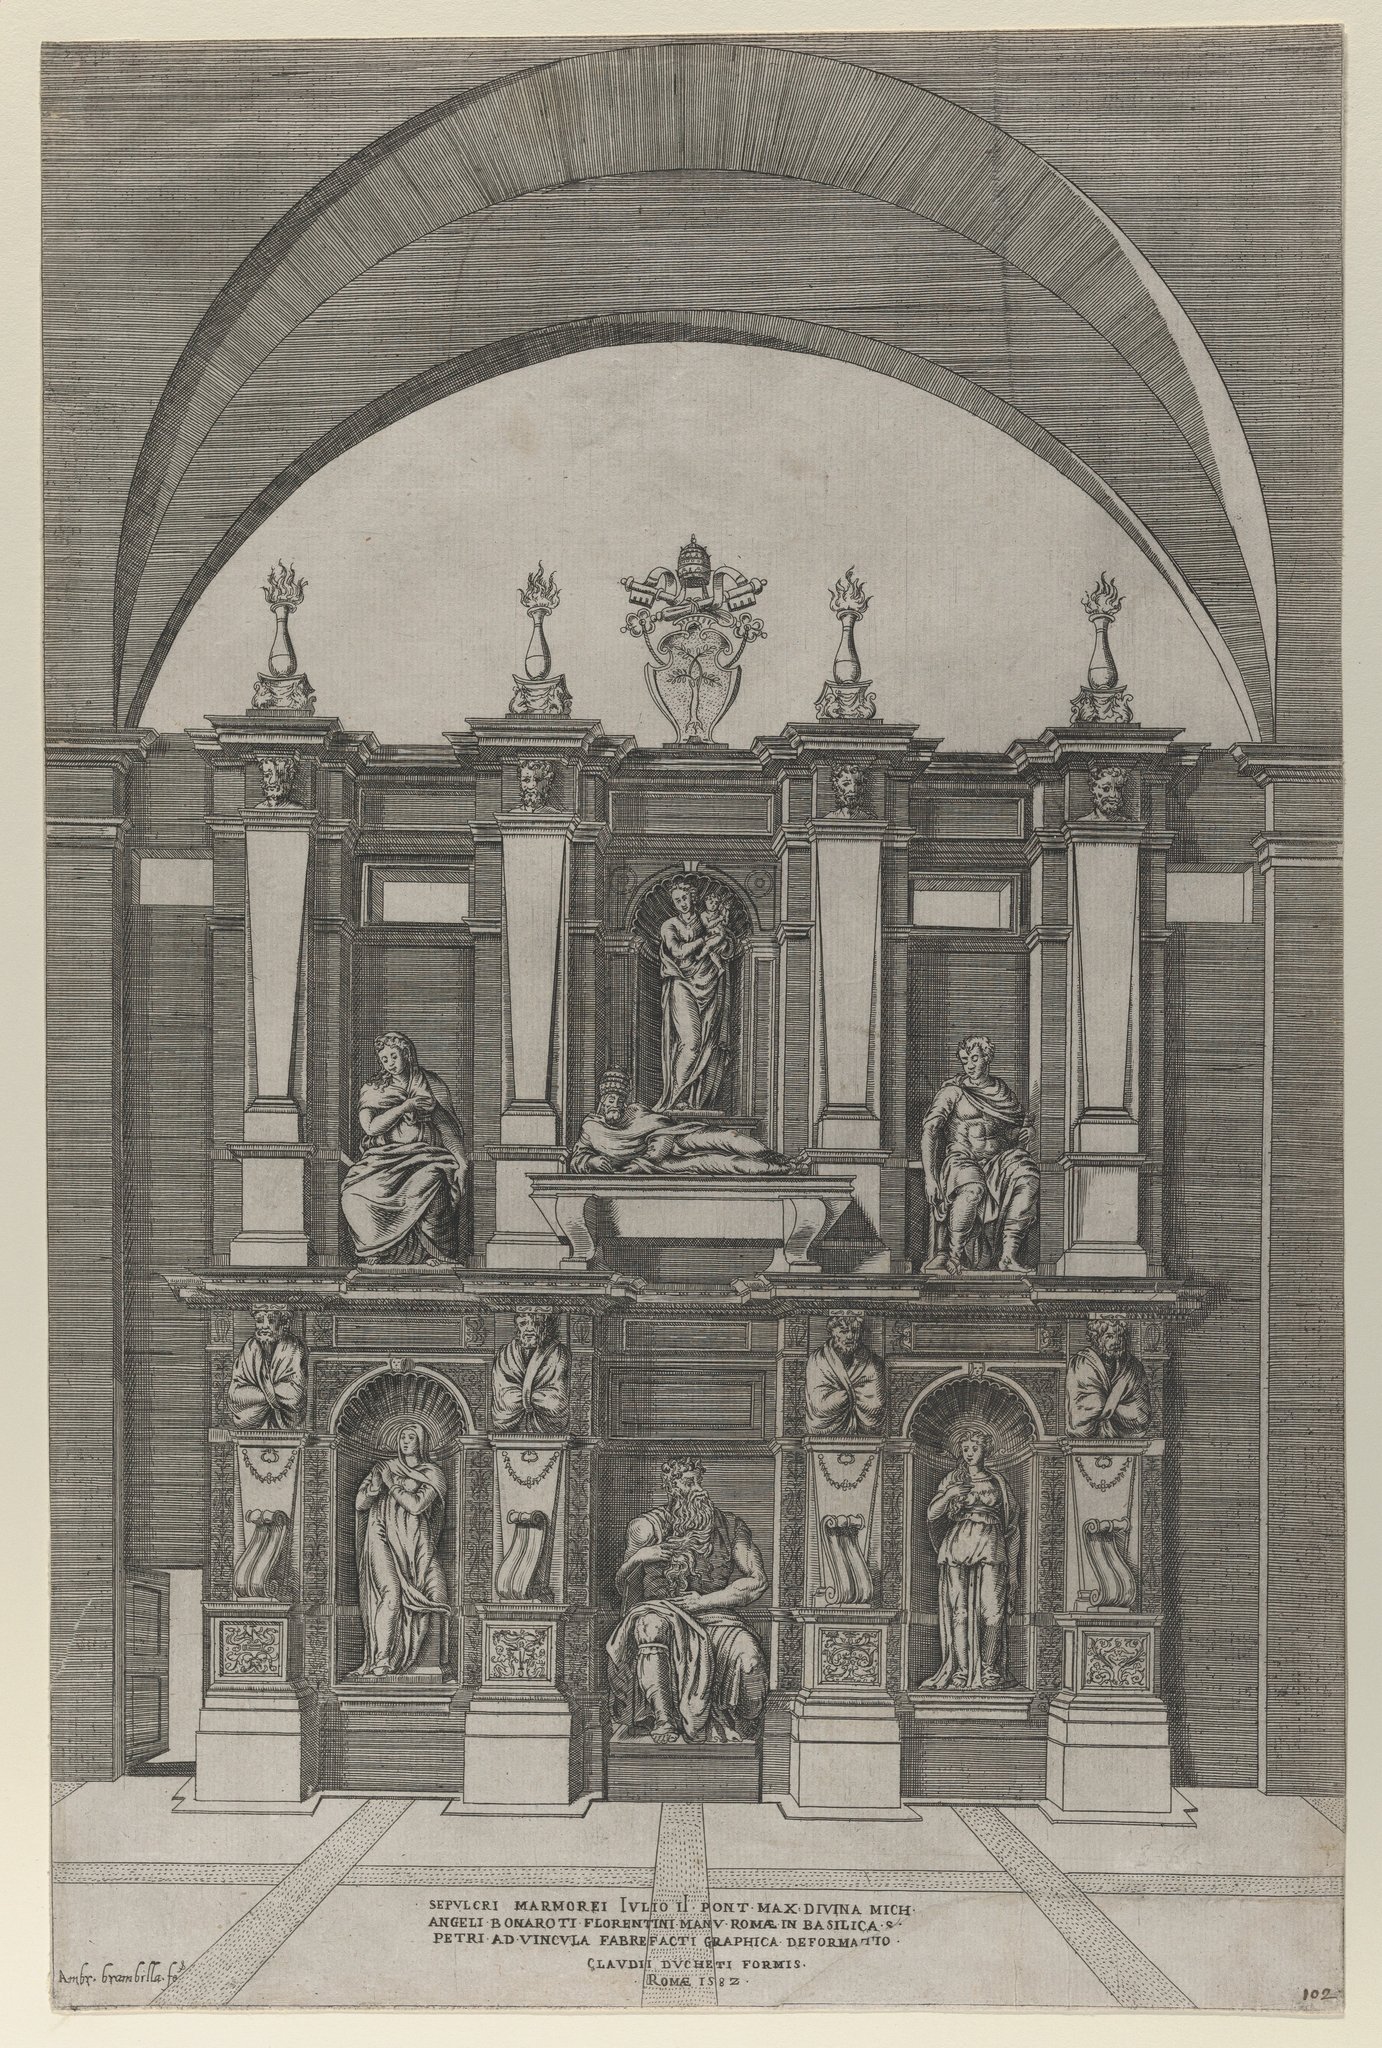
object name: print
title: Sepulchre of Julius II, from "Speculum Romanae Magnificentiae"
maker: giovanni ambrogio brambilla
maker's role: artist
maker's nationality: italian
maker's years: 1575-1599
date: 1582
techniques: engraving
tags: tombs,rome